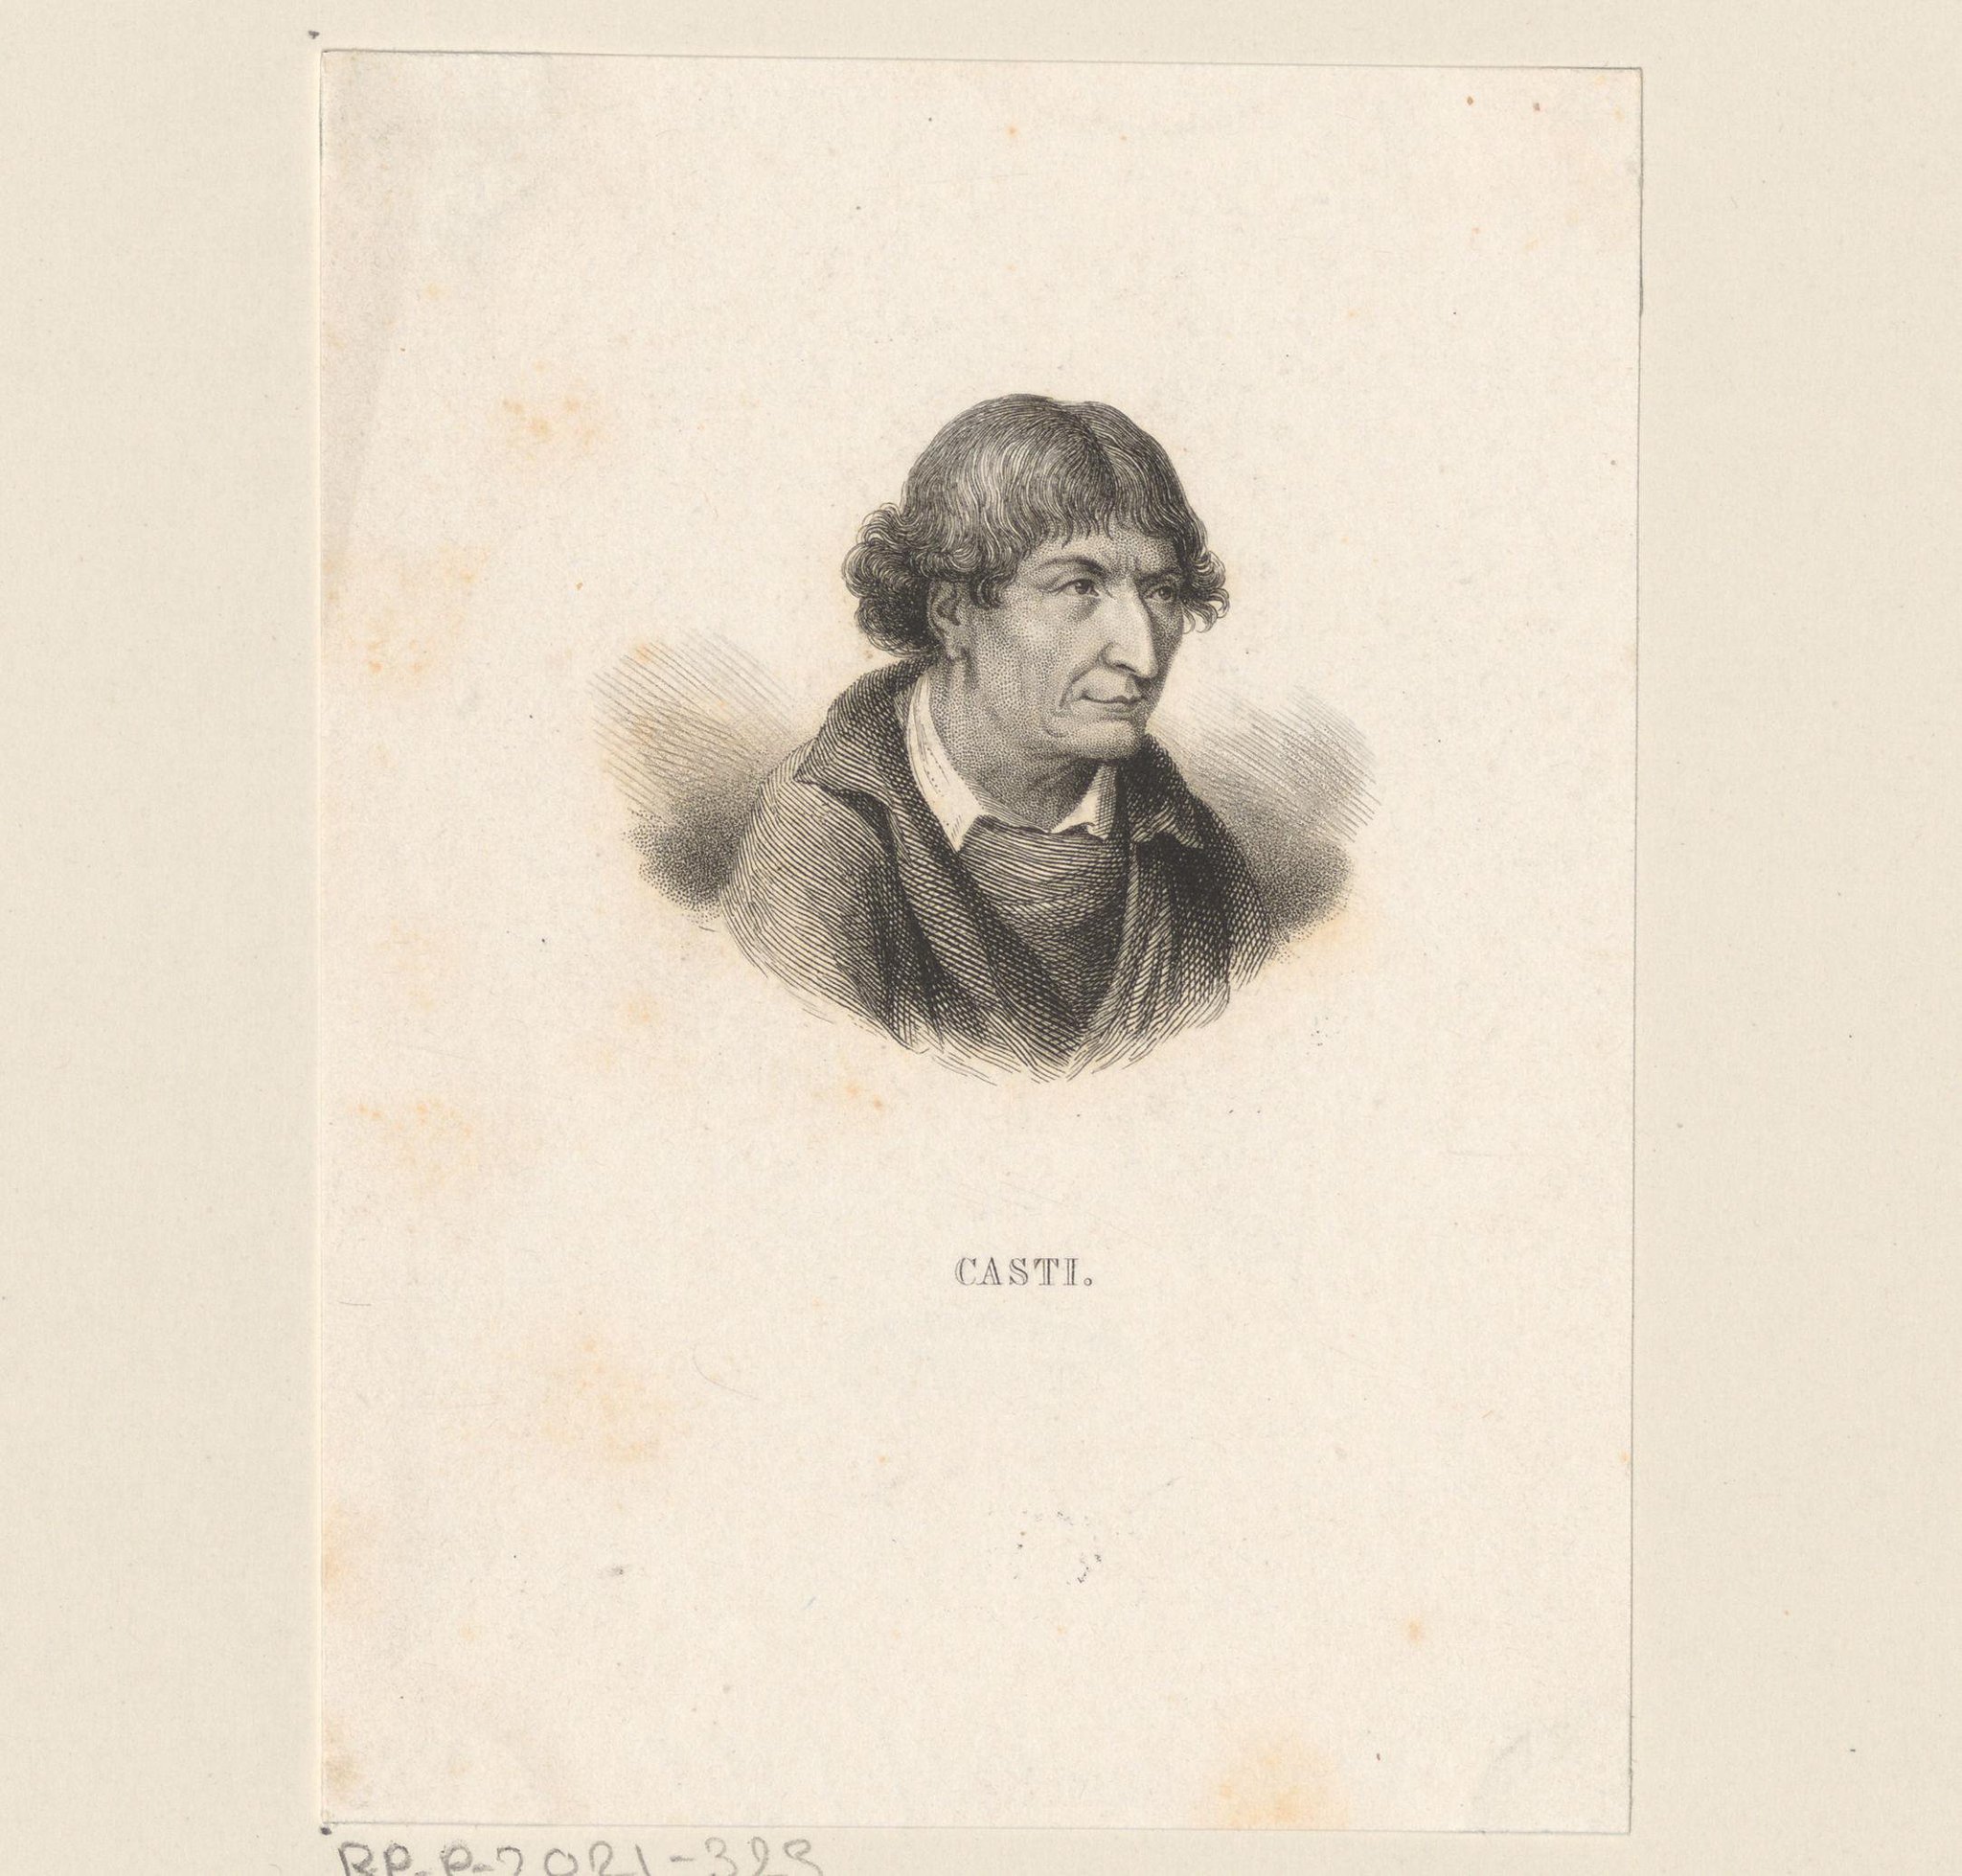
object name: print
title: Portret van Giovanni Battista Casti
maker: Anonymous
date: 1750-1849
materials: paper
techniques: engraving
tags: paris, historical persons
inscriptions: collector's mark: Lugt 2228